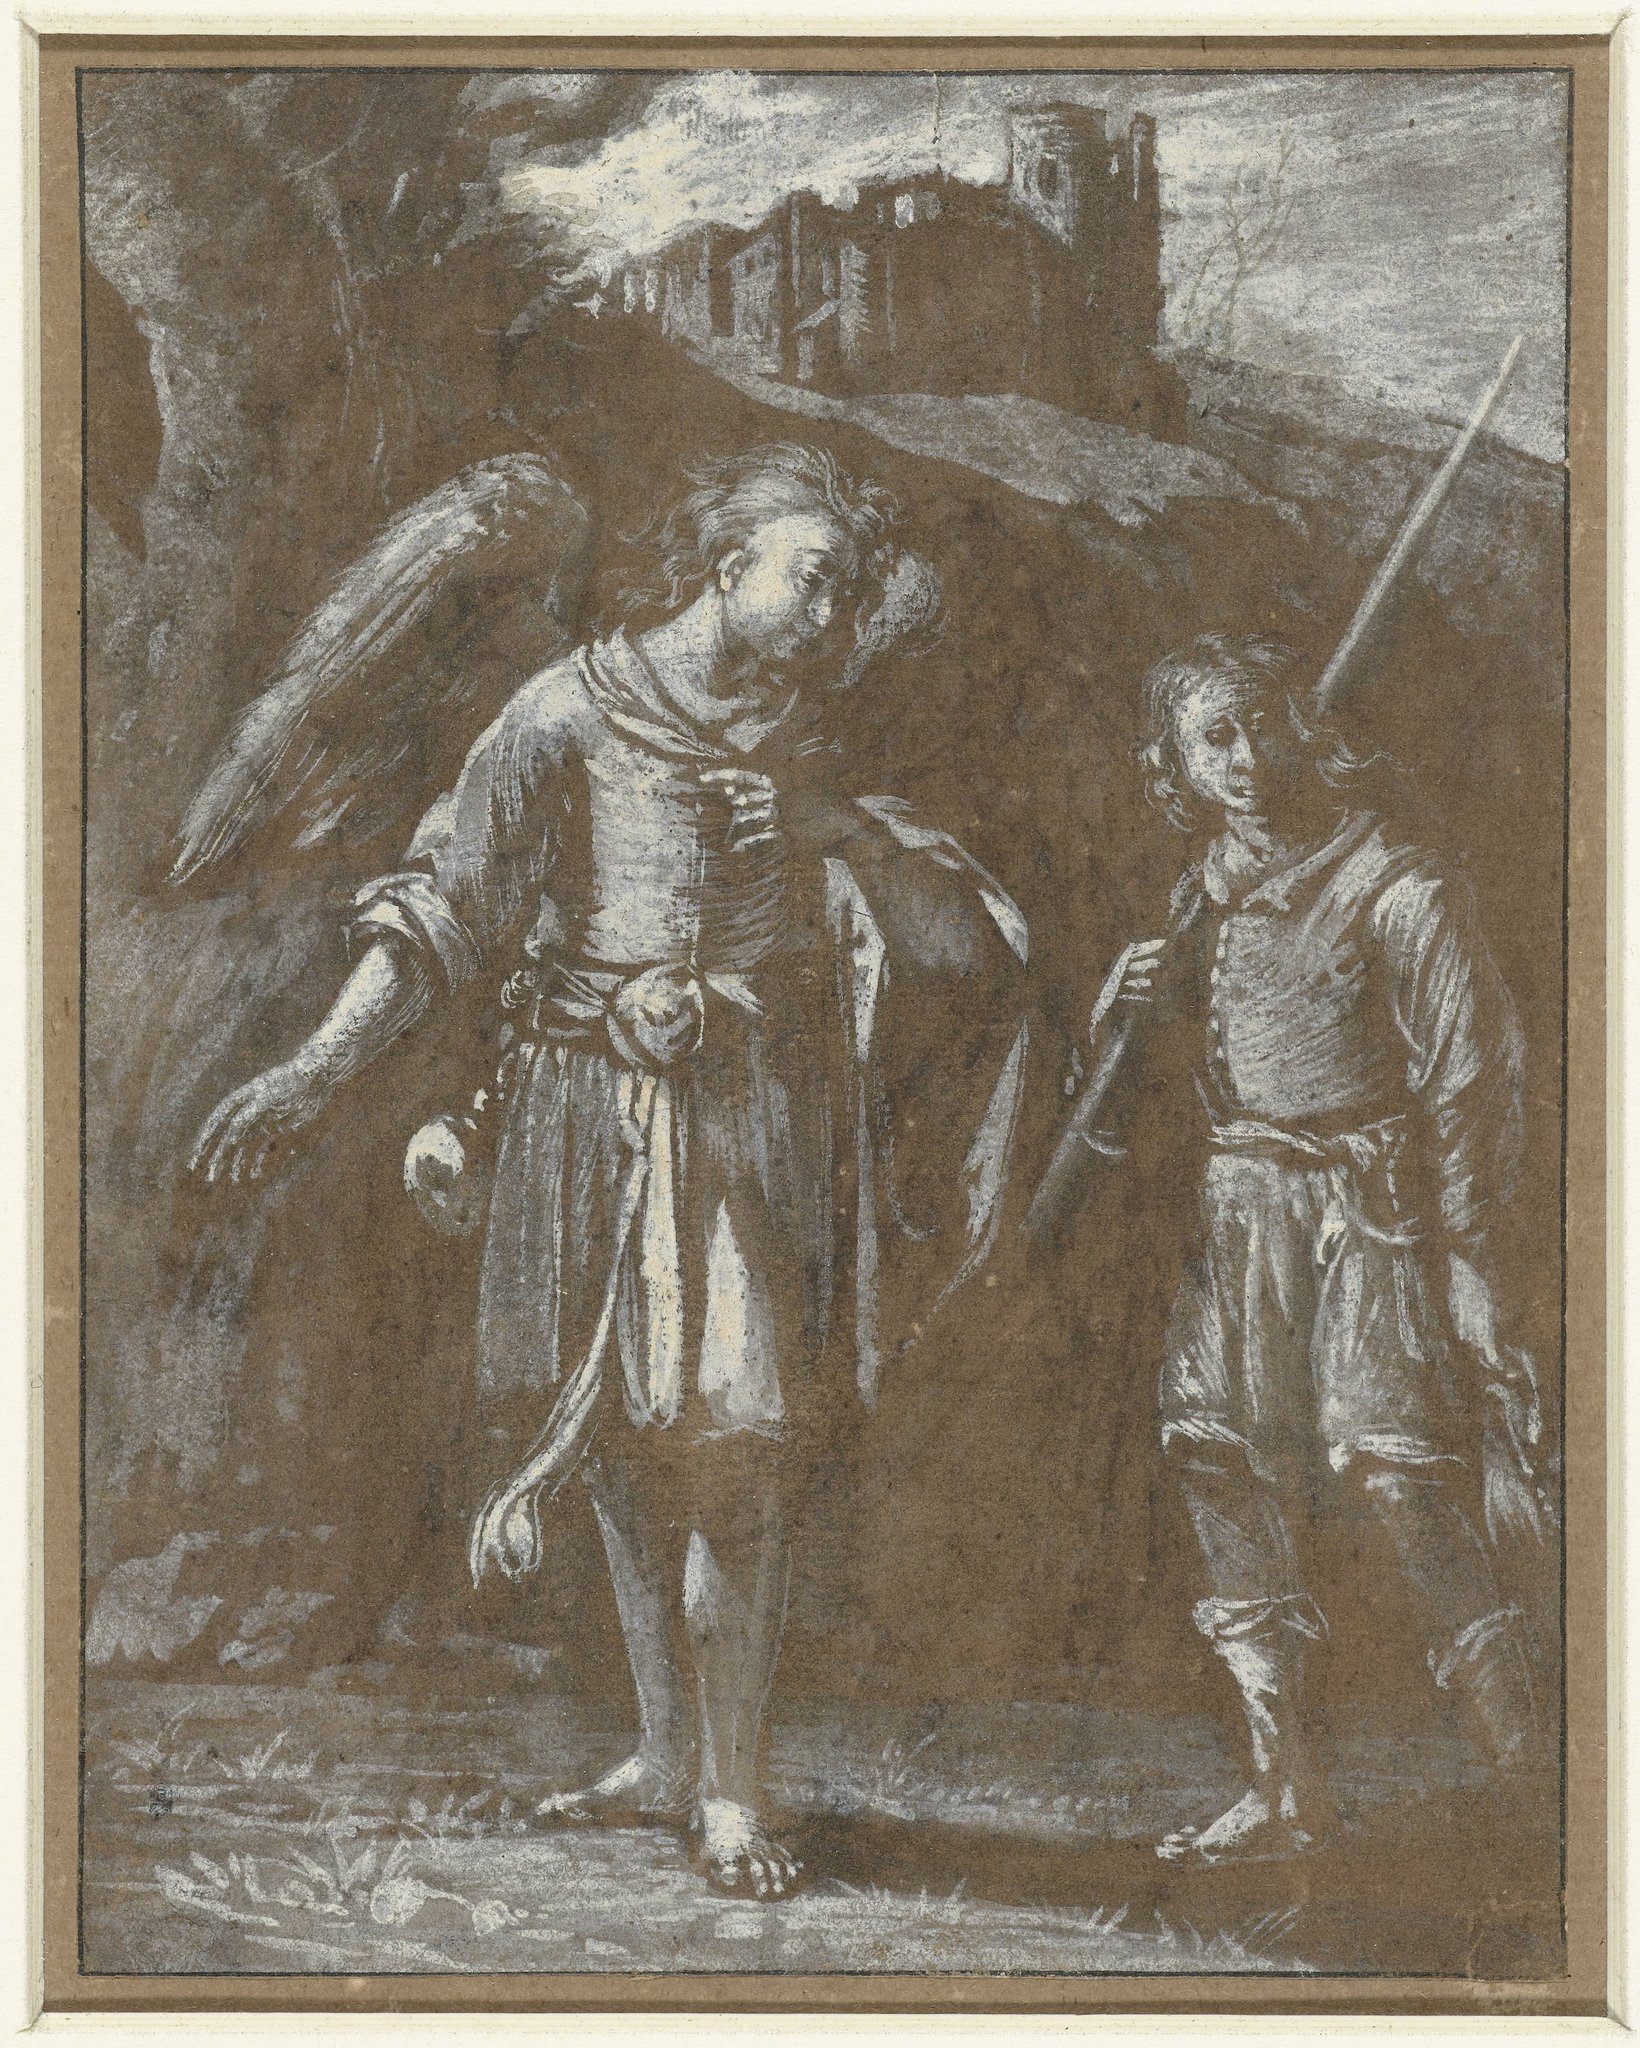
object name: drawing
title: Tobias en de engel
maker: adam elsheimer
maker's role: draughtsman, print maker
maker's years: 1578-1610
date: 1588-1610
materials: paper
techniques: brush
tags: tobias and the angel raphael travelling, accompanied by tobias' dog